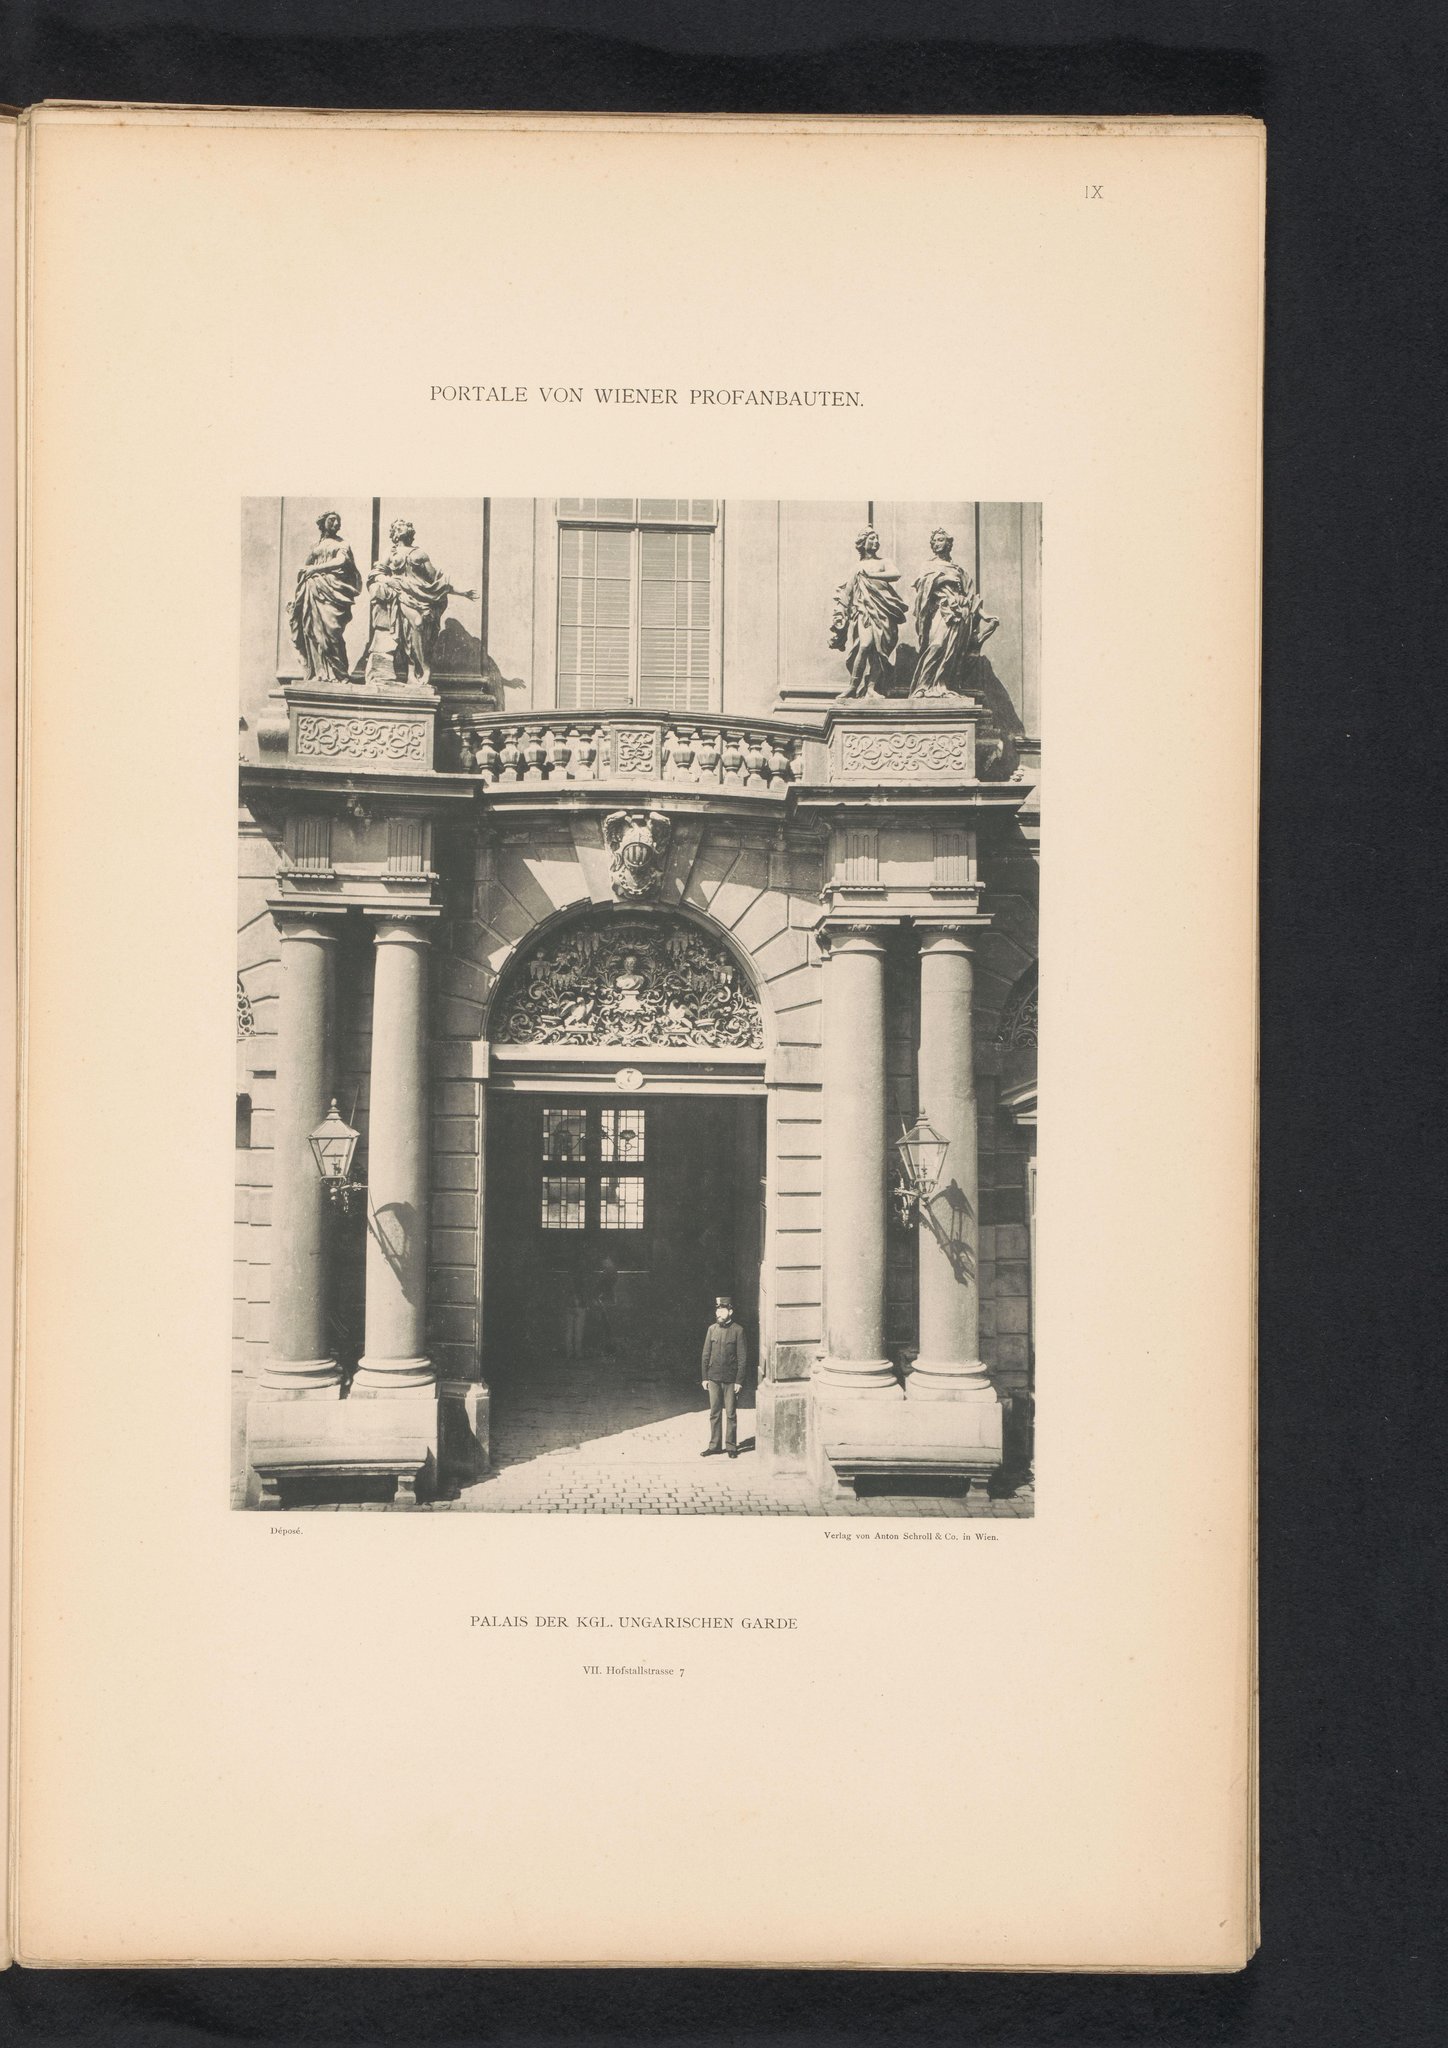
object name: page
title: Palais der kgl. Ungarischen Garde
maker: Anonymous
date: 1884-1894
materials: paper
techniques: photograph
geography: austria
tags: gate, entrance, façade (of house or building)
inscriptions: inscription: ‘I. Hofstallstrasse 7’, number: ‘IX.’